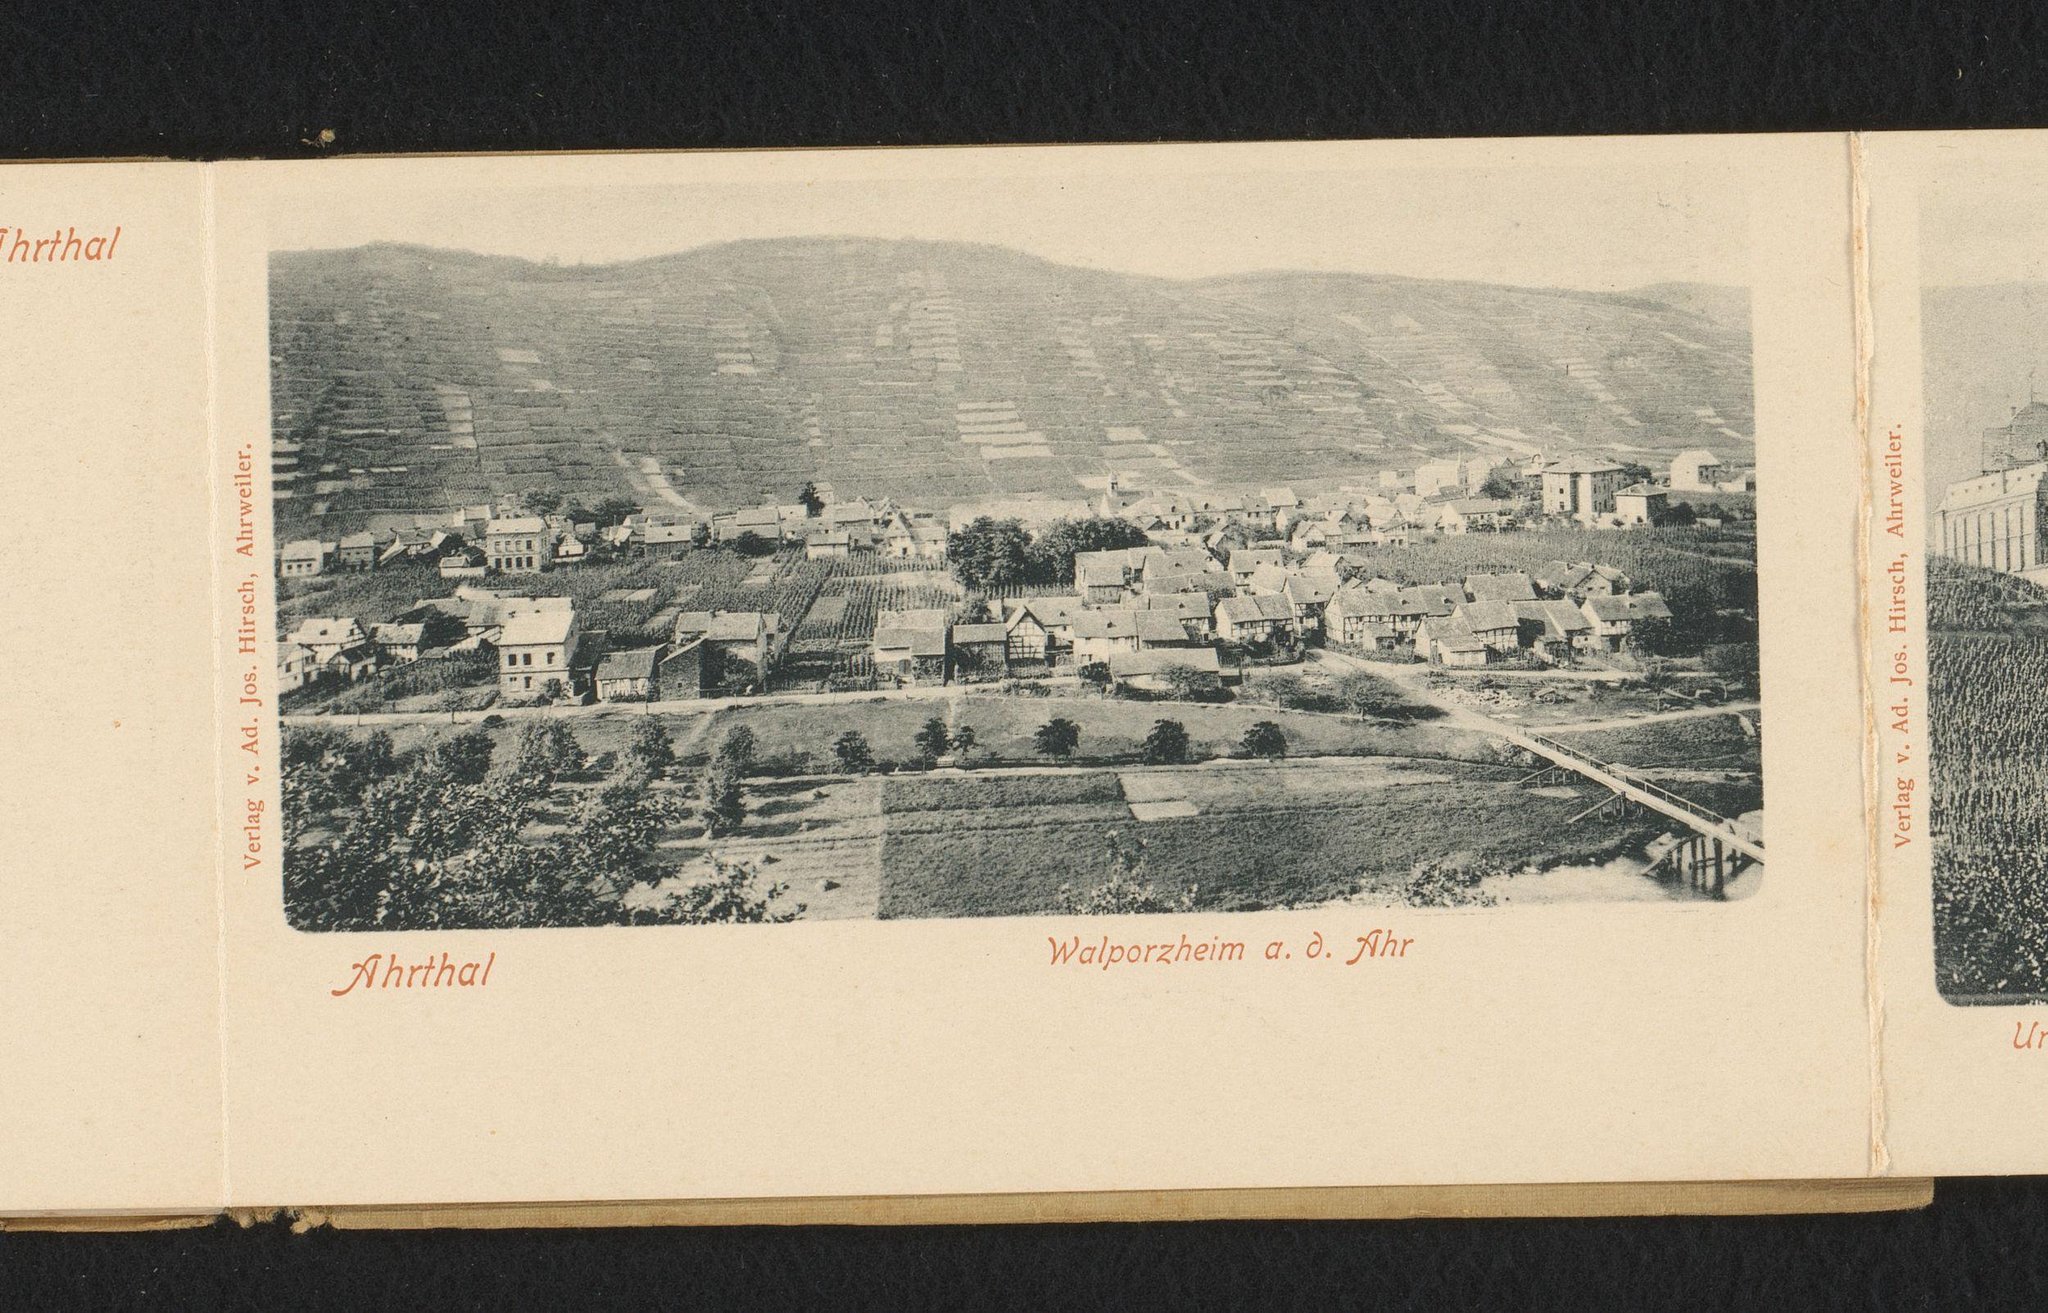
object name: ansichtkaart, prentbriefkaart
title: Ahrthal. Walporzheim a.d. Ahr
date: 1885-1903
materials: cardboard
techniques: photograph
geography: walporzheim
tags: city-view, and landscape with man-made constructions, mountains